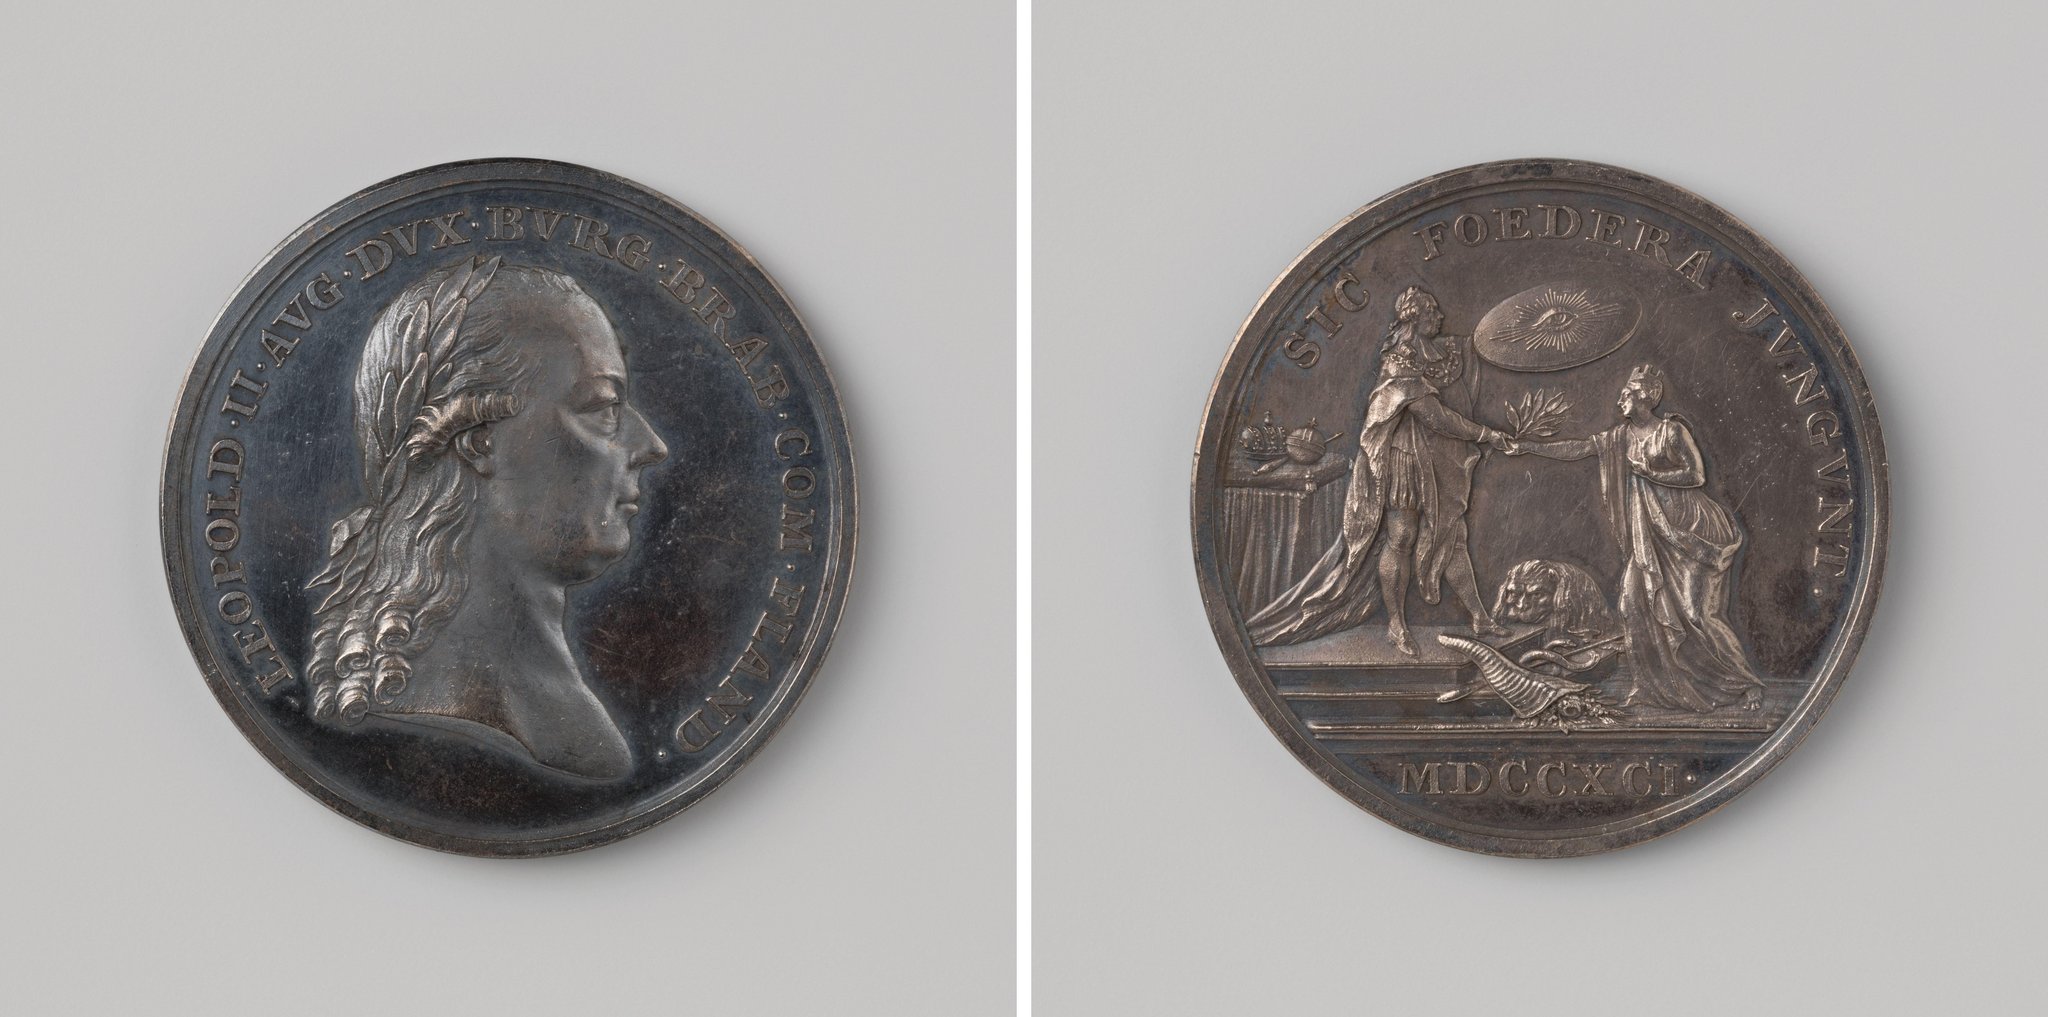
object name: history medal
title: Inhuldiging van Leopold II, Duits keizer, als graaf van Vlaanderen en hertog van Brabant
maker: theodorus victor van berckel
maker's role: mintmaster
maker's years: 1739-1808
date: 1791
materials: silver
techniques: striking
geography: brussels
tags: vienna, leopold ii (keizer van oostenrijk), brabant